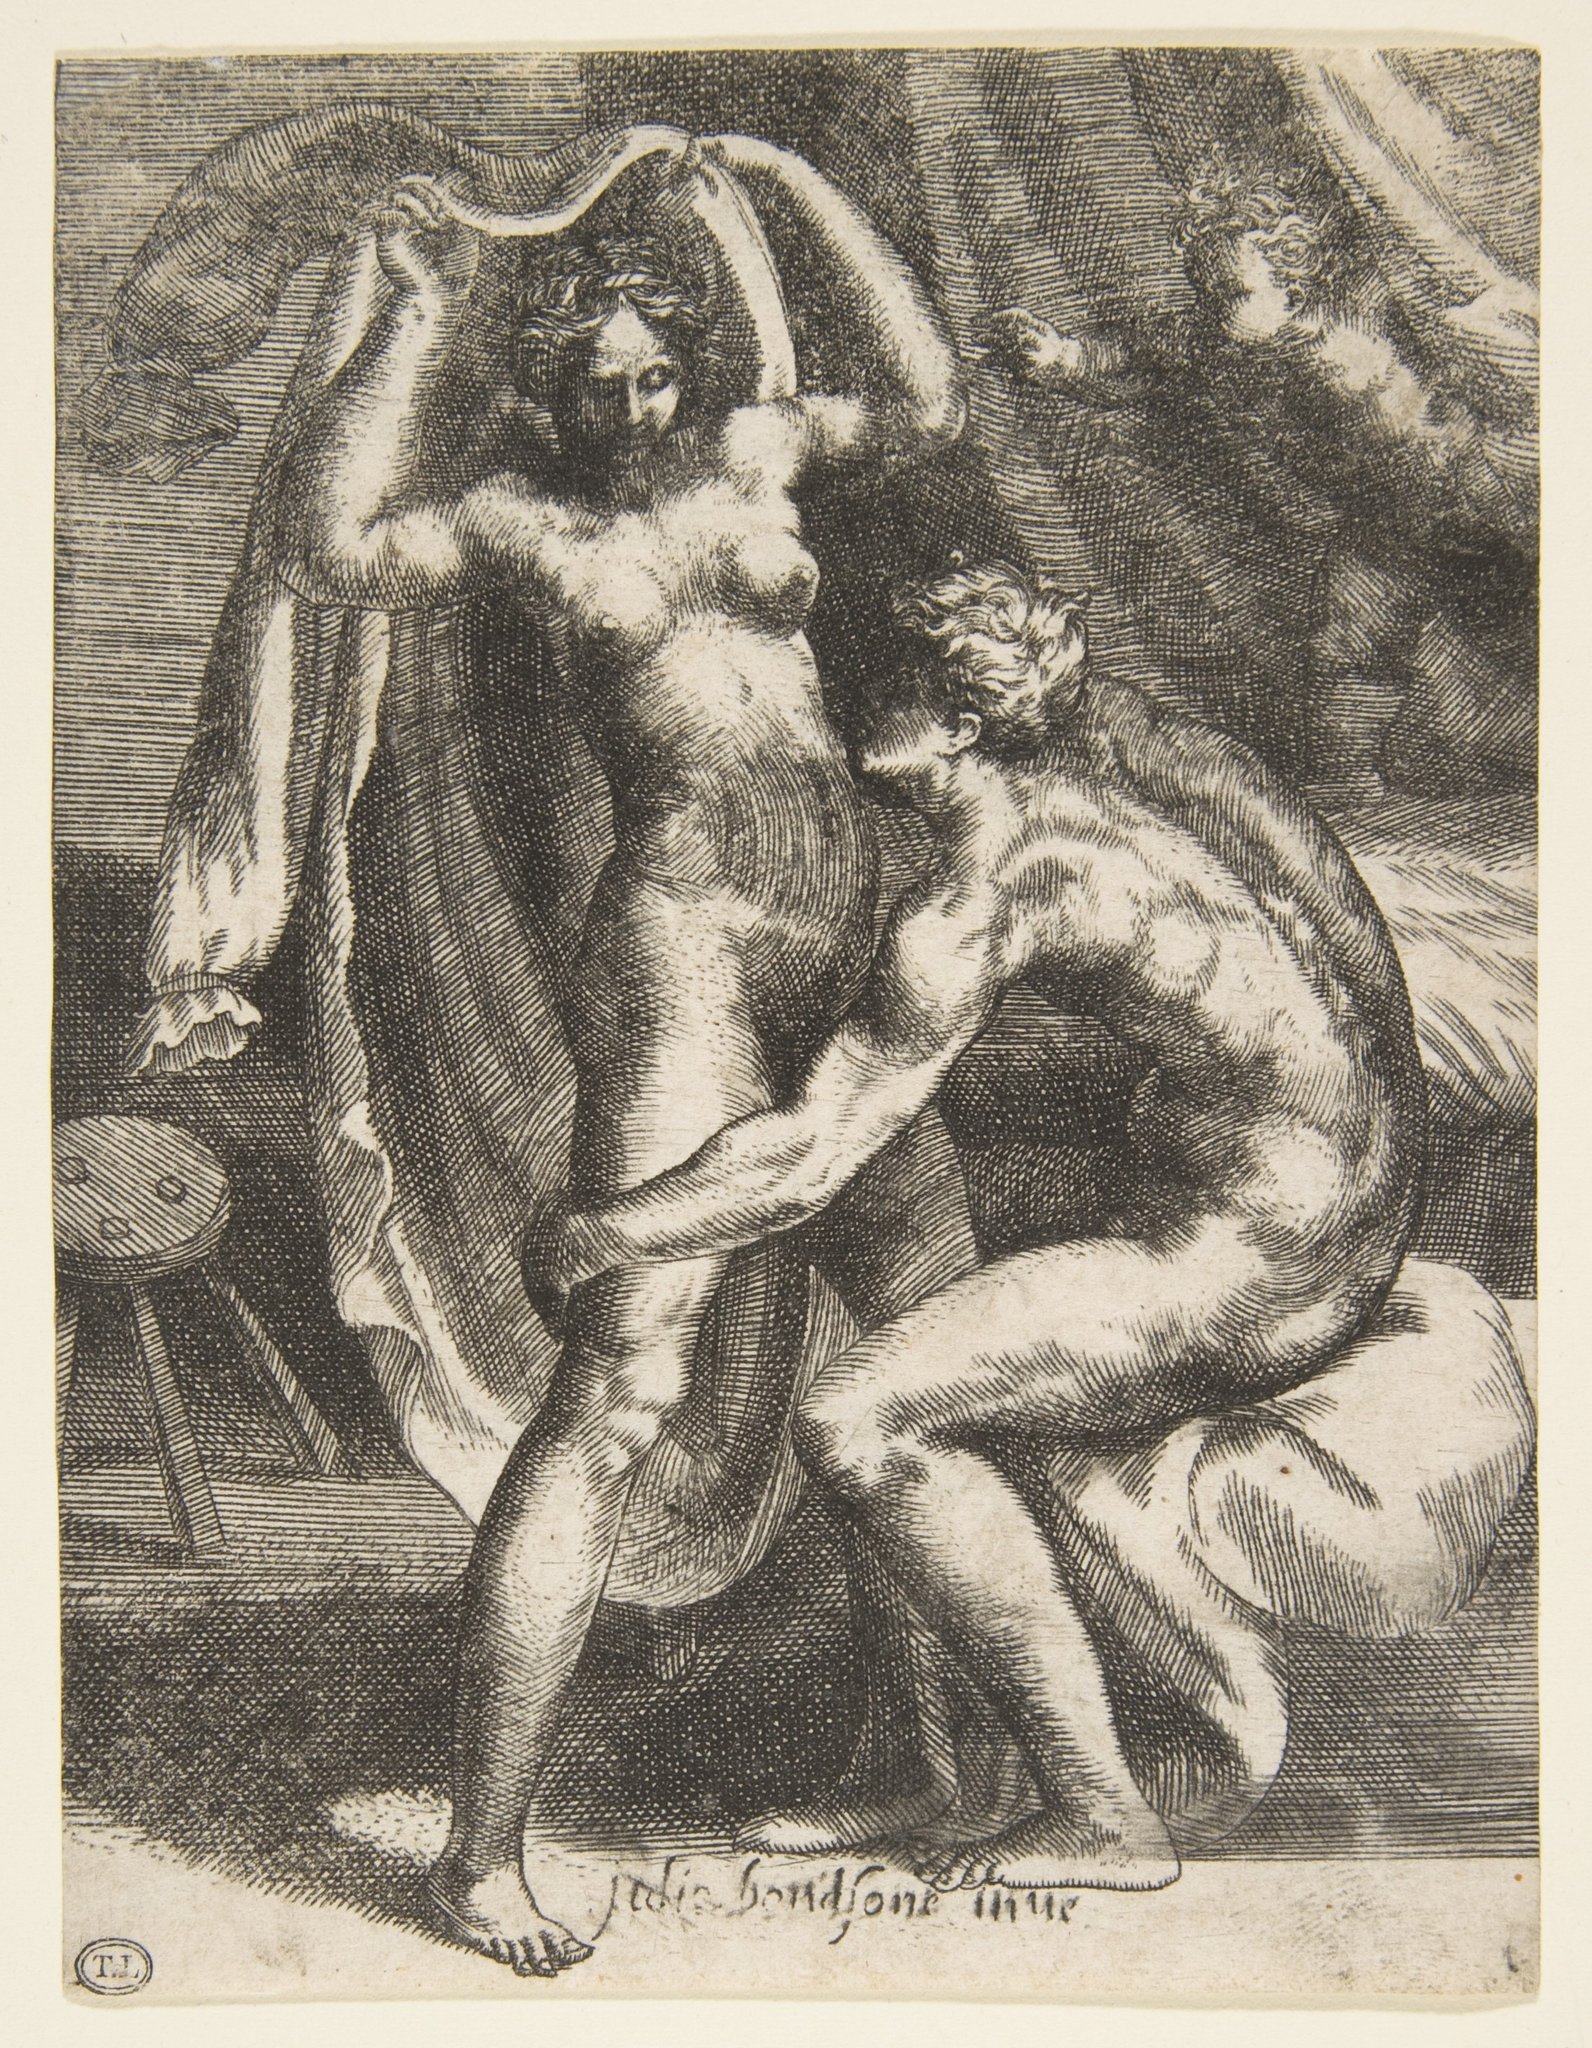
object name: print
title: Two lovers, a man pulling a woman toward a bed, from "The Loves of the Gods"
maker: giulio bonasone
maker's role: artist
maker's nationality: italian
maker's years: 1510-1576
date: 1531-1560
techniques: engraving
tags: male nudes,lovers,female nudes,beds